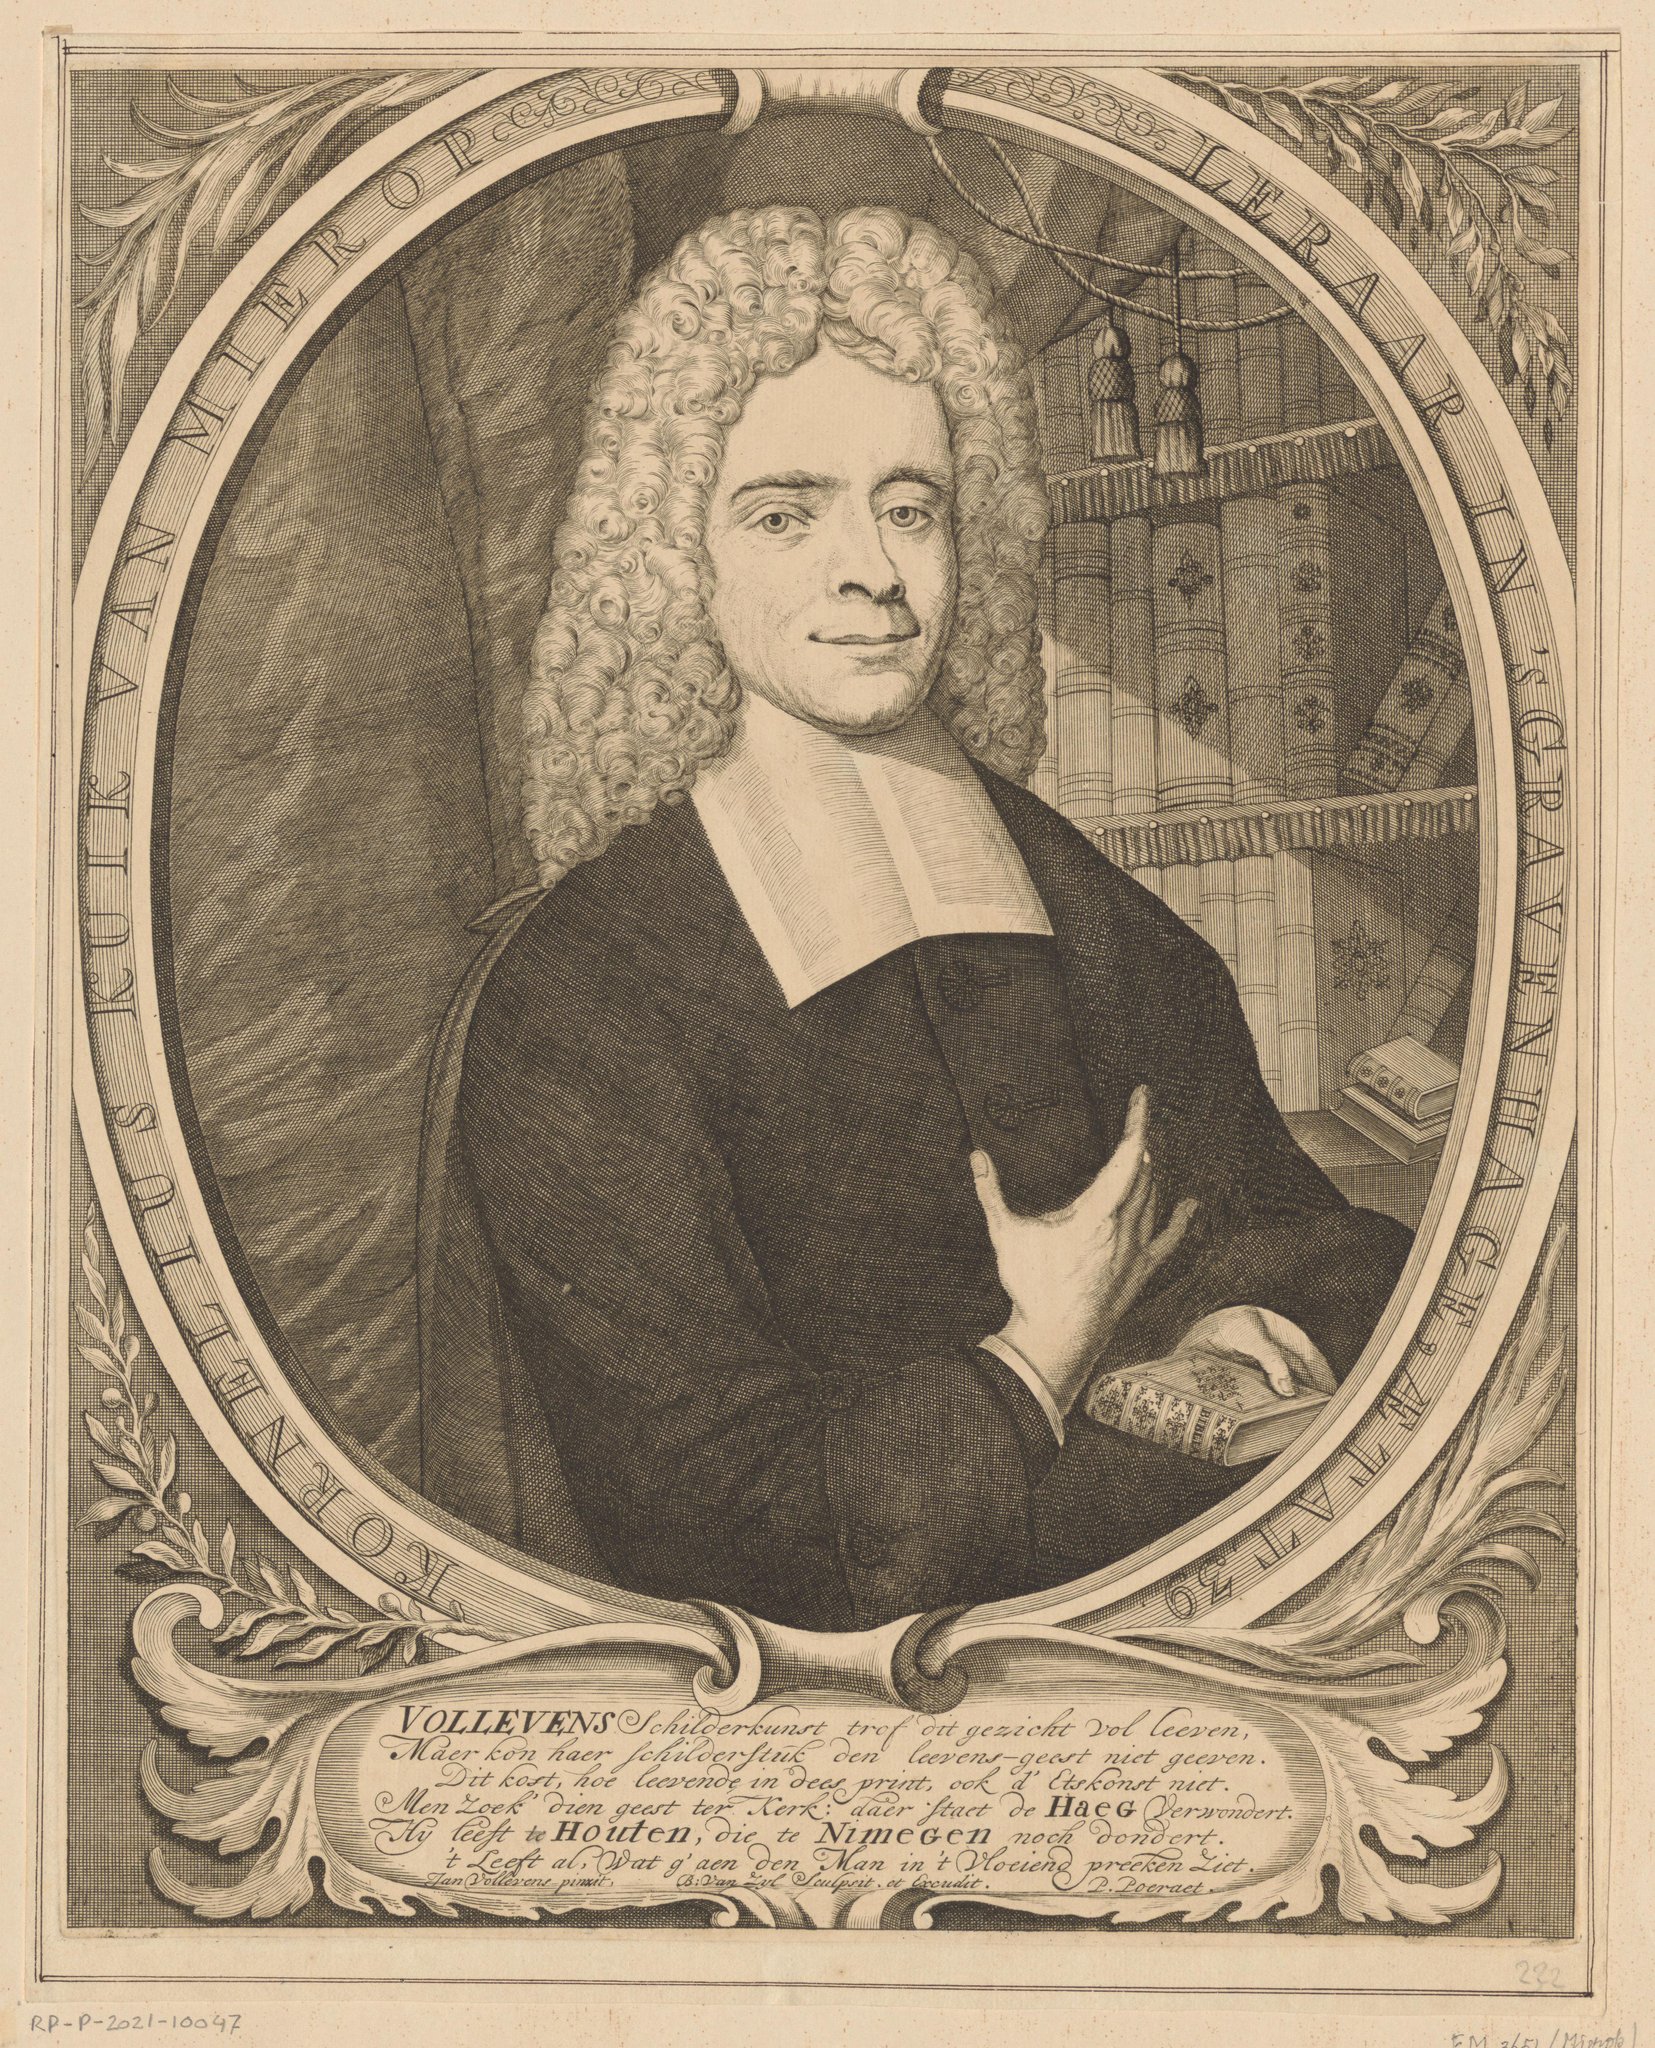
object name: print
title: Portret van Kornelius Kuik van Mierop op 39-jarige leeftijd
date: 1709-1718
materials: paper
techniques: engraving, etching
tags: utrecht, the hague, bookshelves, historical persons, book